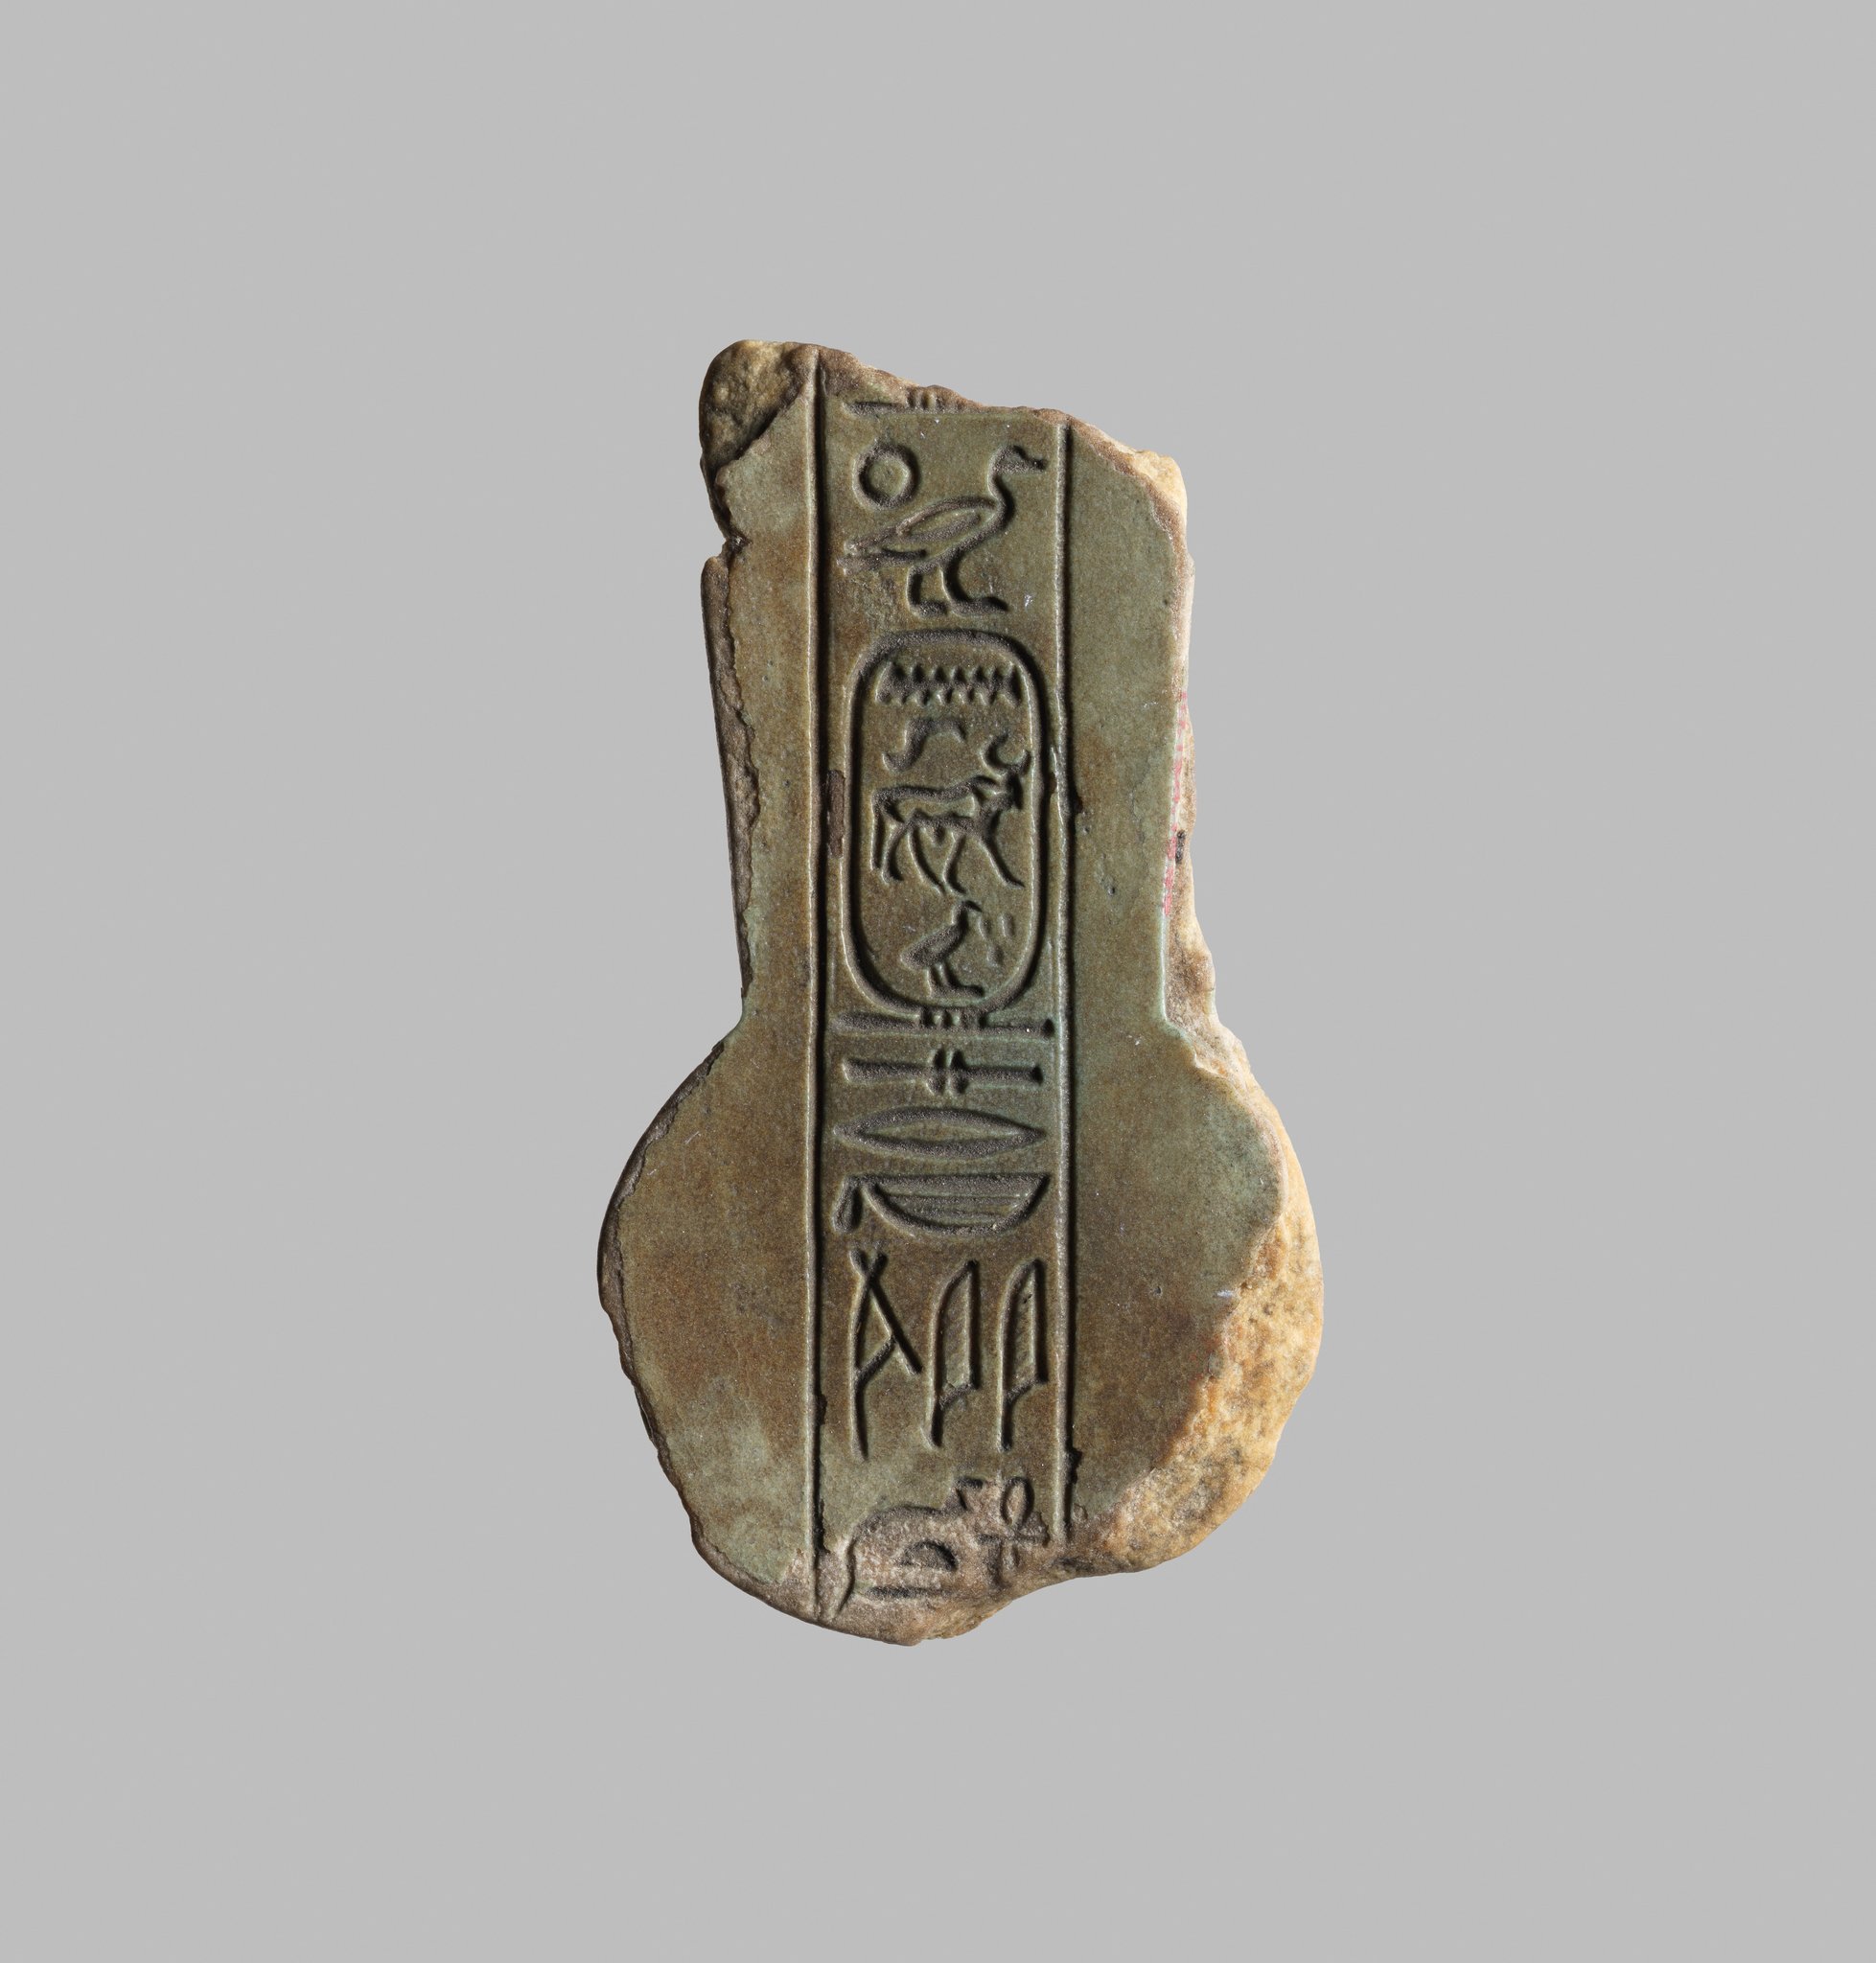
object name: menat fragment, necho i or ii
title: Menat fragment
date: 672-595 BCE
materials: limestone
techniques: glazing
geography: egypt